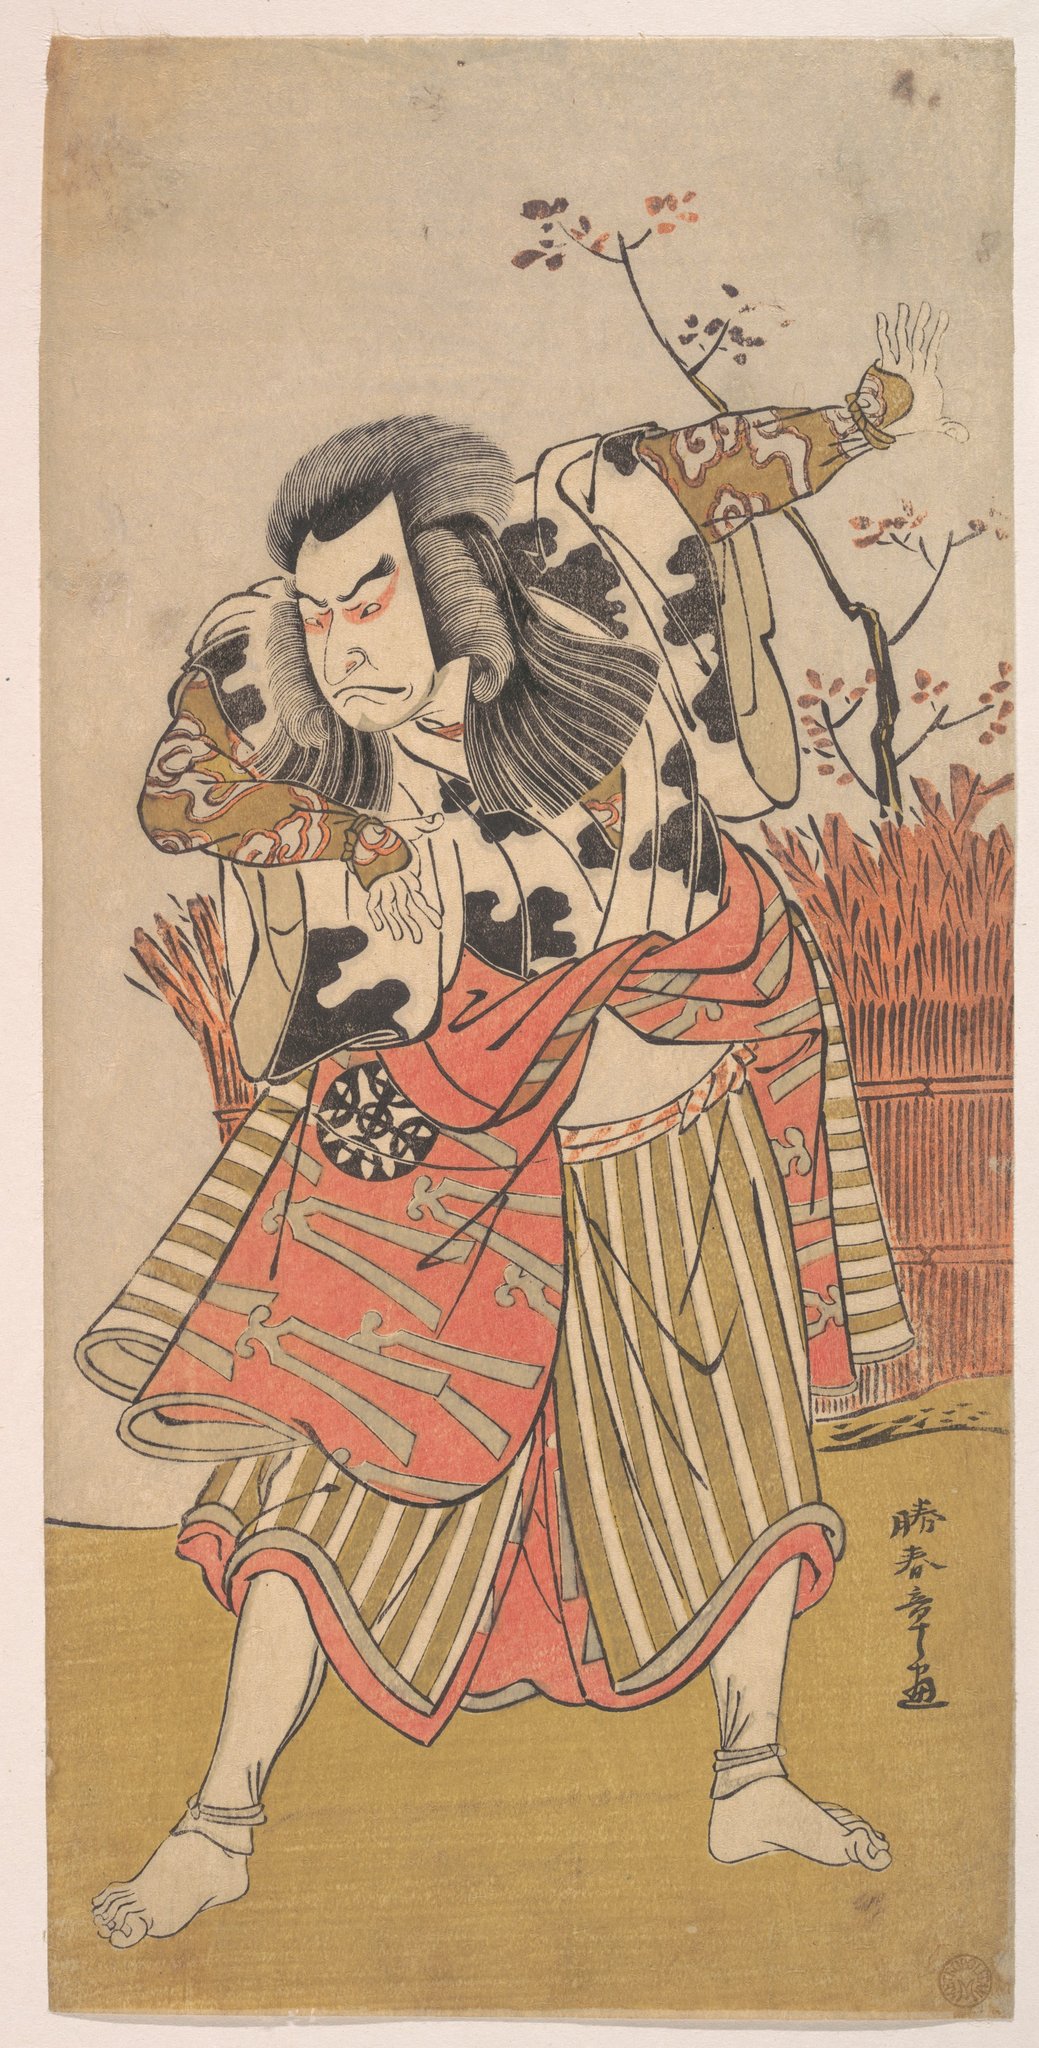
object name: woodblock print nishiki e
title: The First Nakamura Nakazo as an Unarmed Man Standing in a Dramatic Pose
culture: japanese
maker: katsukawa shunshō 勝川春章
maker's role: artist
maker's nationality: japanese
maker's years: 1726-1792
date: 1777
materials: ink, paper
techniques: nishiki e, woodblock print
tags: men,actors